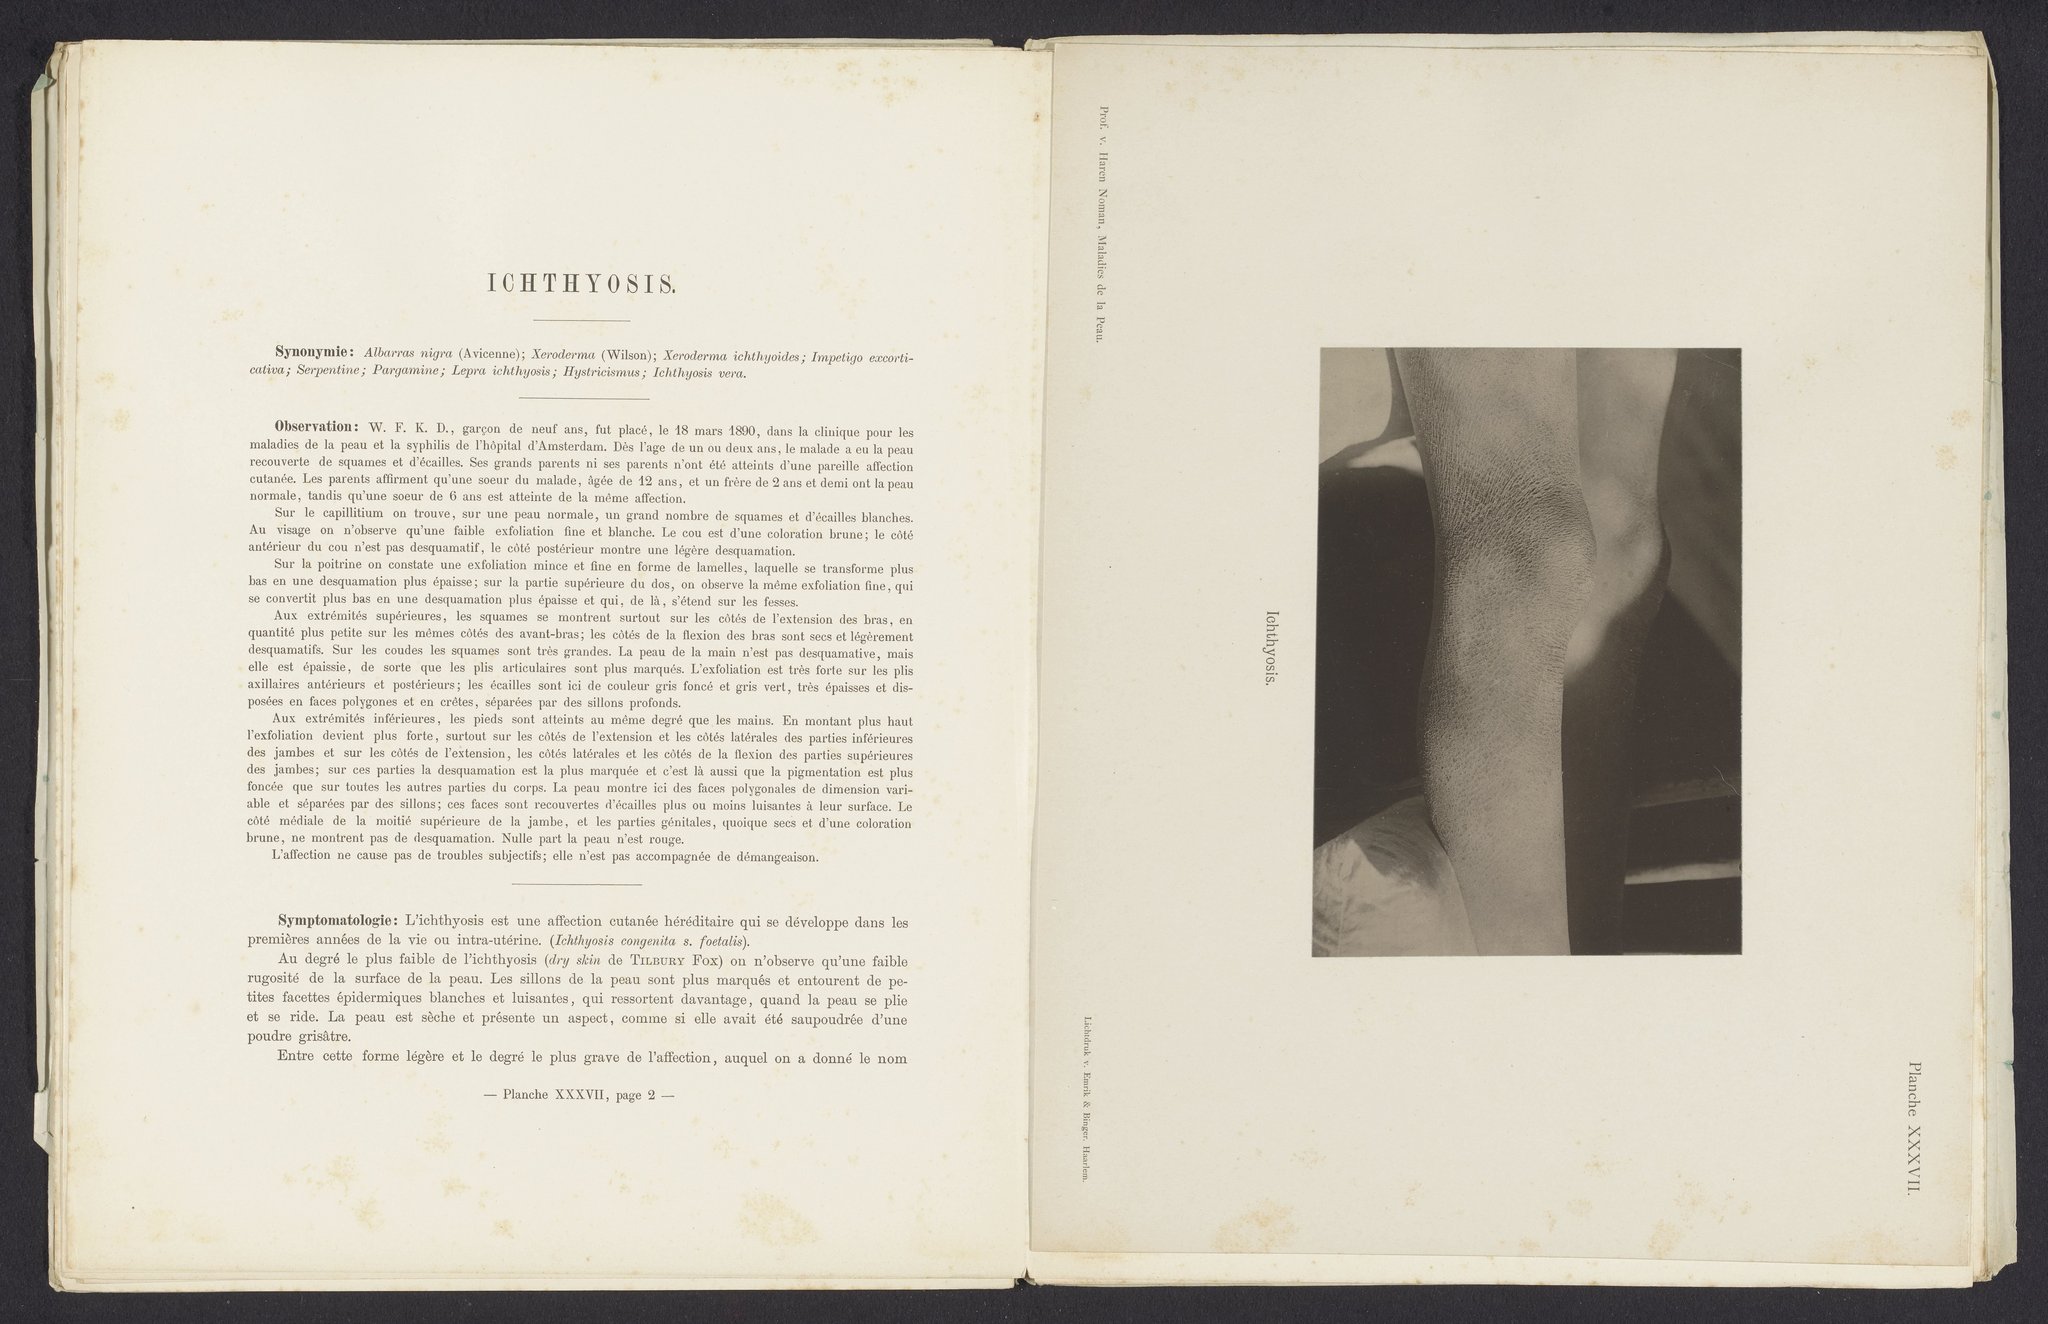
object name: photomechanical print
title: Ichthyosis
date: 1882-1892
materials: paper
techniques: photograph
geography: haarlem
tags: skin and venereal diseases, legs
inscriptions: number: ‘Planche XXXVII.’